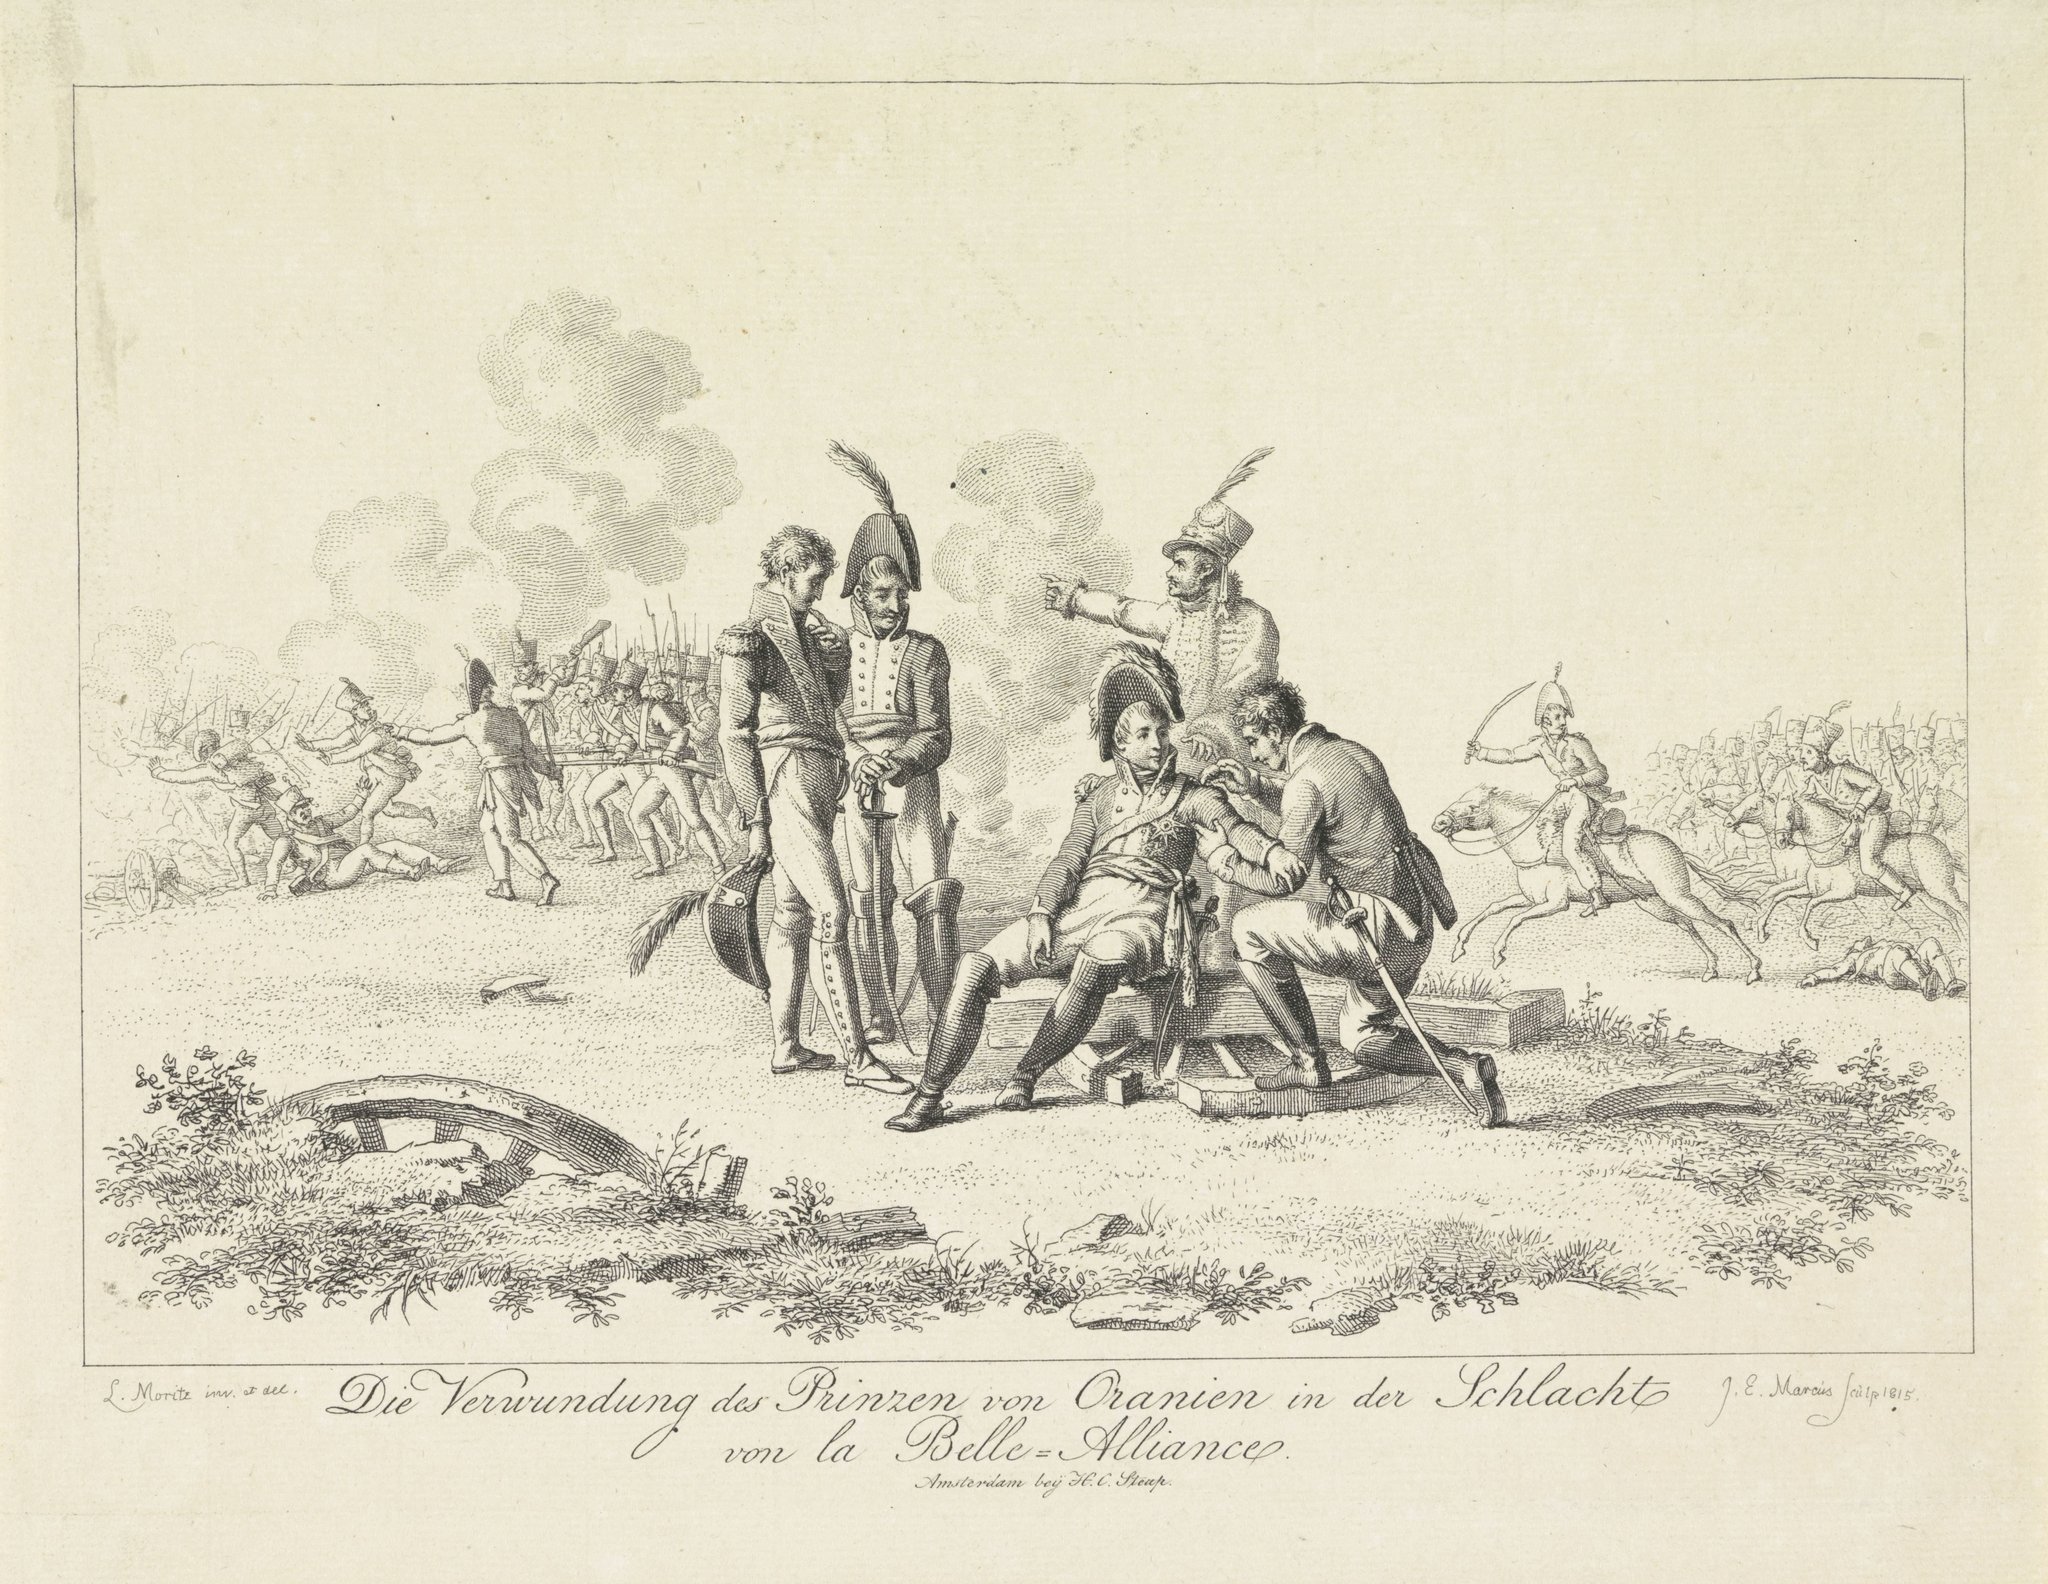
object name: print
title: Prins van Oranje raakt gewond tijdens de slag bij Waterloo, 1815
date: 1815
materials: paper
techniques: engraving, etching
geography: netherlands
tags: william ii of the netherlands, medical aid and nursing of the sick and wounded on the battlefield, battle (+ land forces), waterloo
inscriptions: collector's mark: Lugt 2228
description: Willem Frederik George, prins van Oranje, tijdens de slag bij Waterloo op 18 juni 1815 gewond geraakt aan de linkerschouder, wordt door een chirurgijn onderzocht. Links en op de achtergrond zware gevechten. Bij de prins staan enkele officieren.